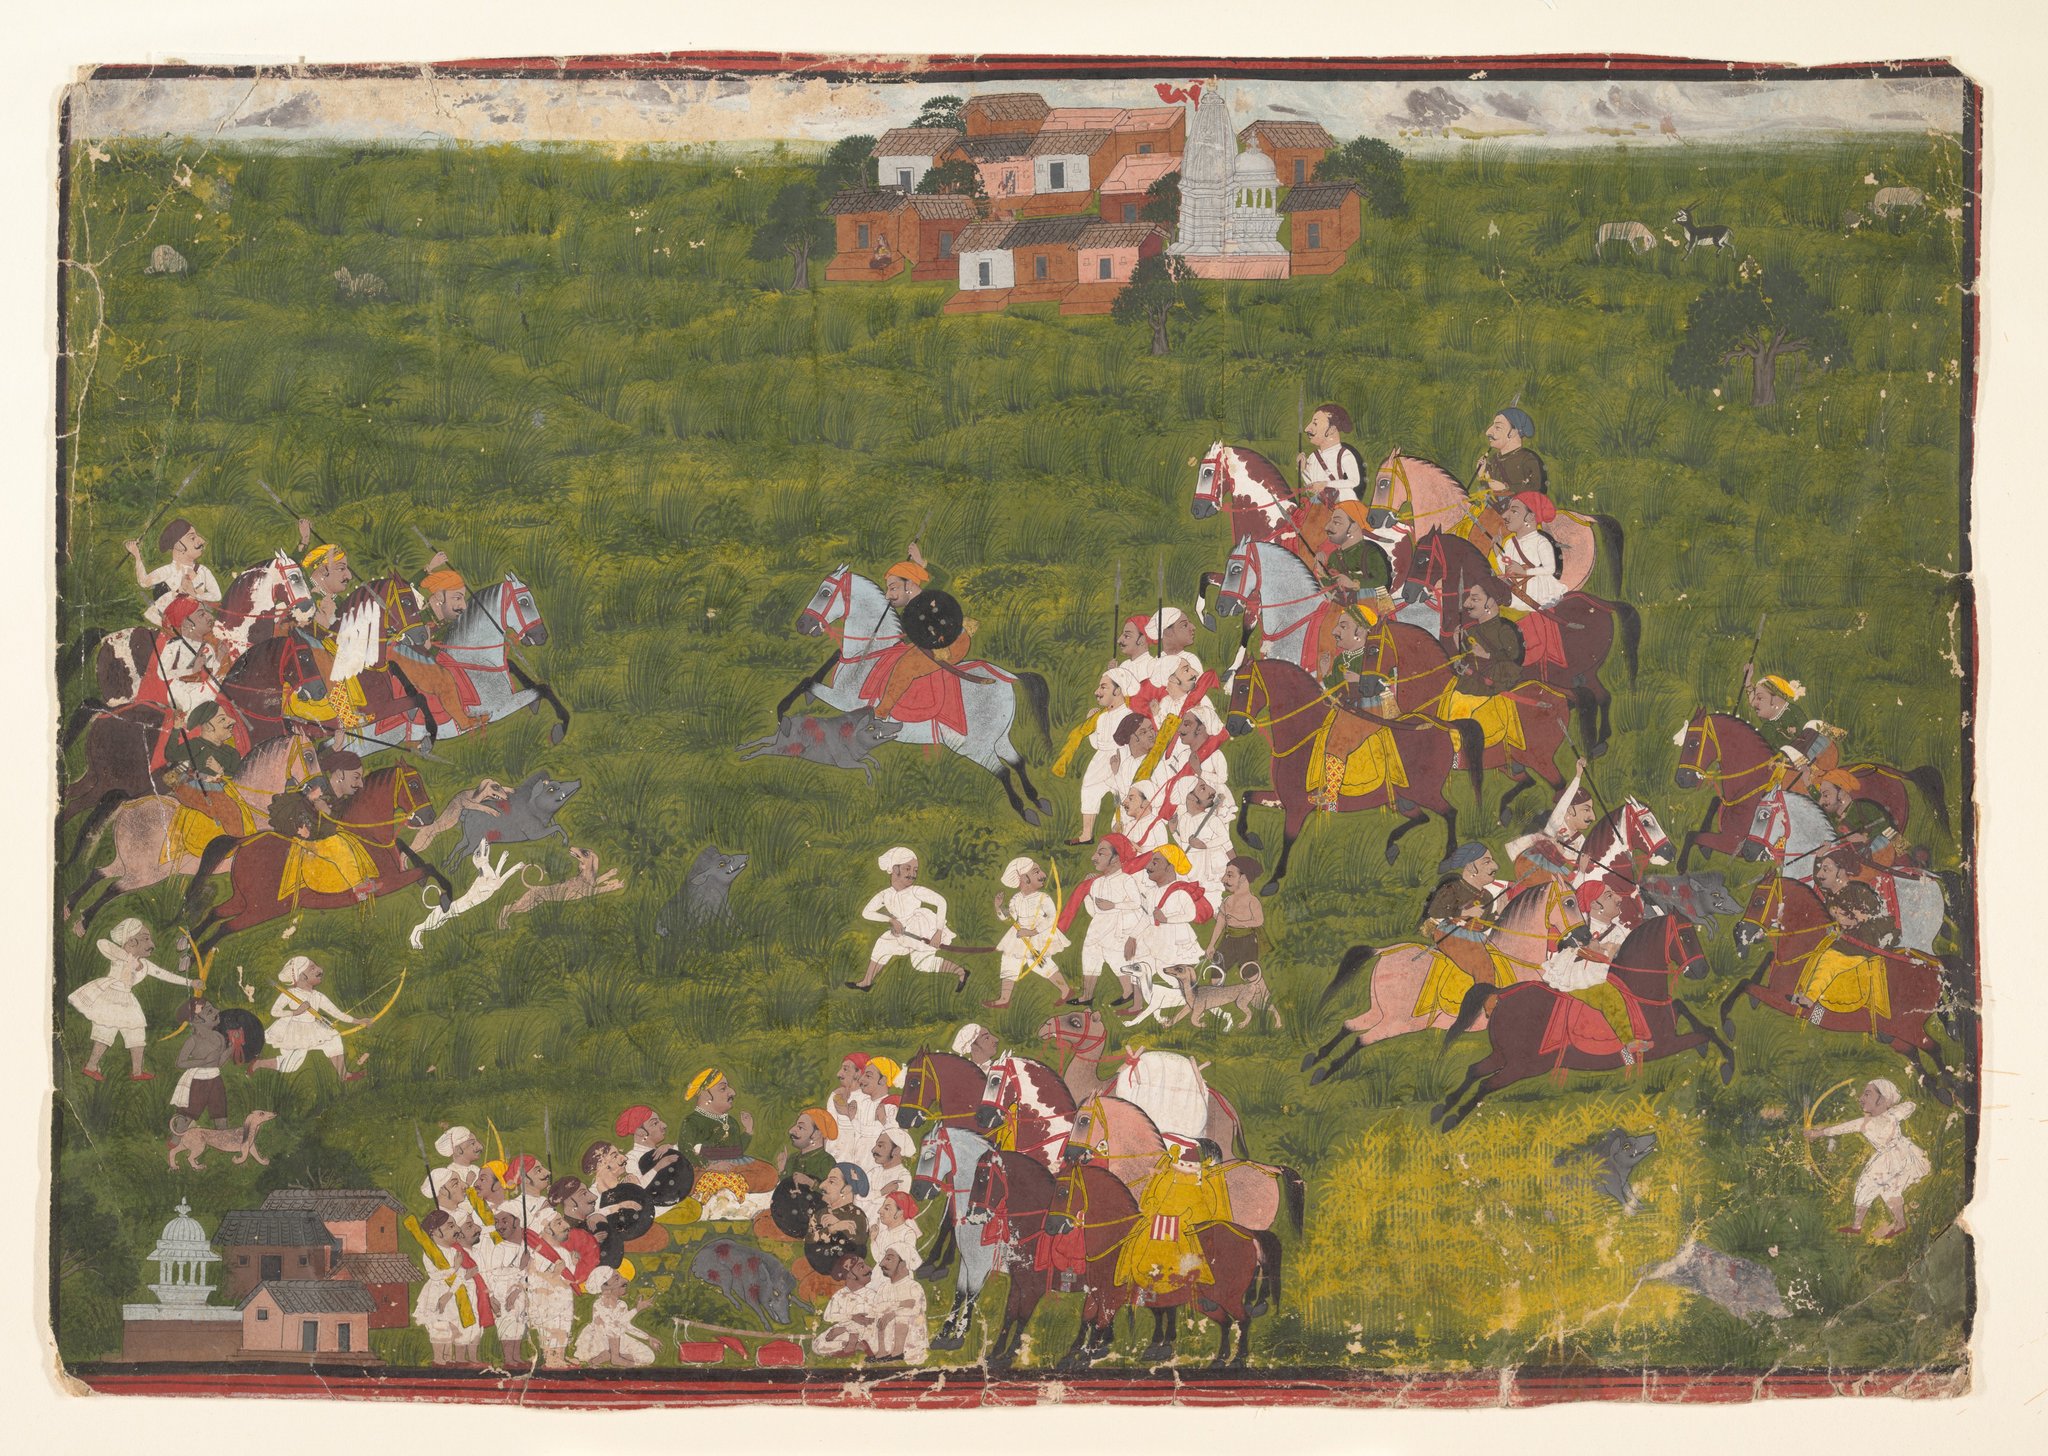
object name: painting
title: Maharana Sangram Singh Hunting Wild Boar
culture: western indian, rajasthan, udaipur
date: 1725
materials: ink, paper, watercolor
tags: men,hunting,boars,horses